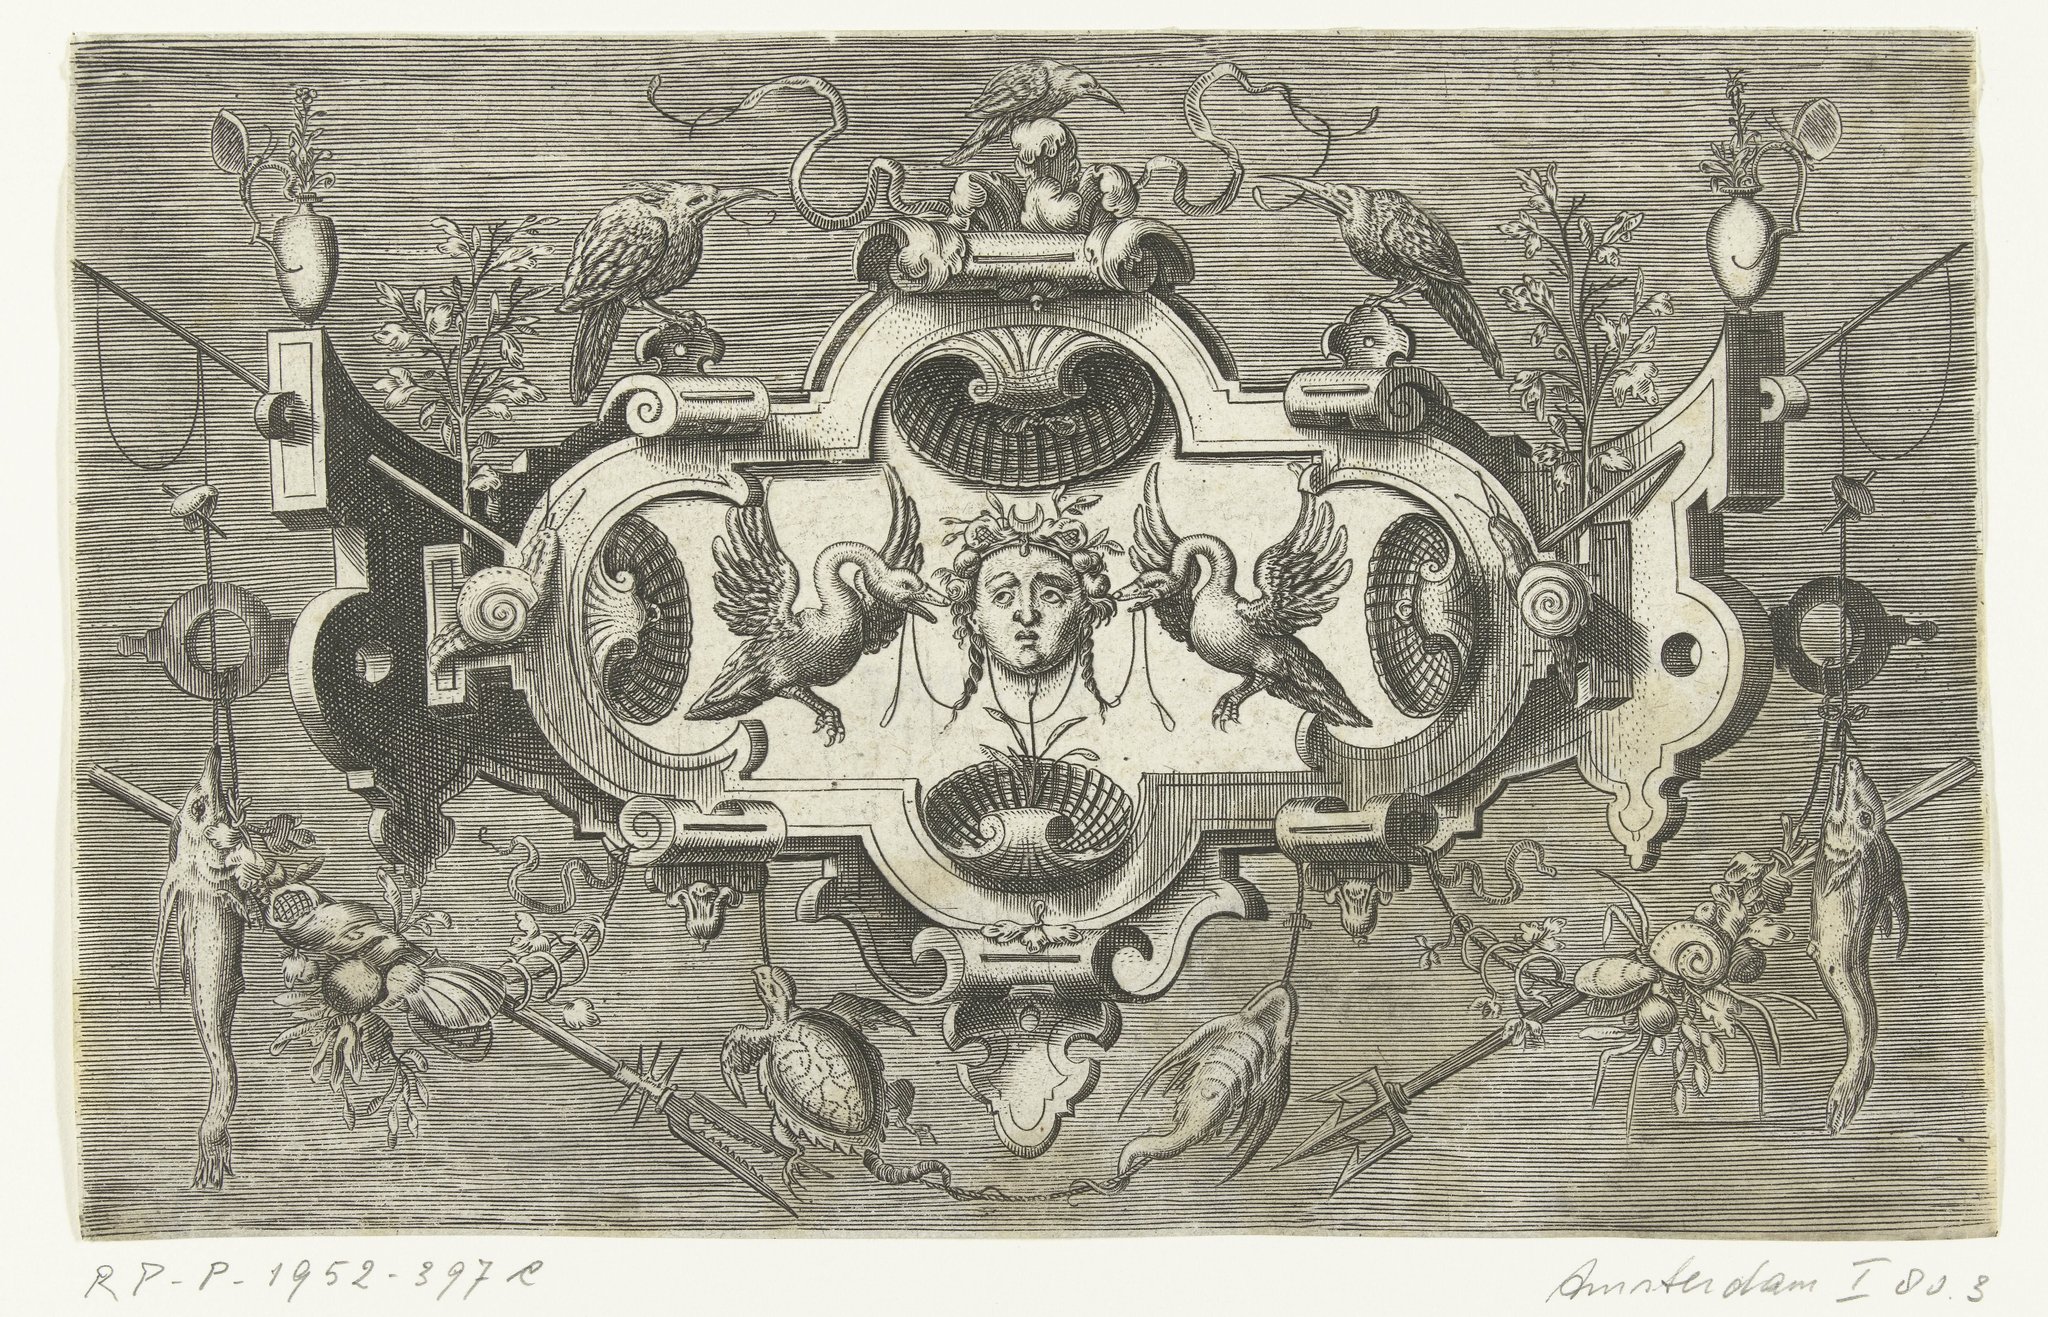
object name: print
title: Cartouche met vier schelpen en een mascaron geflankeerd door twee zwanen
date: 1564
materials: paper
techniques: engraving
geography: antwerp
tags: tortoises, turtles, water-birds: swan, birds, fishes, scallop, shell ~ ornament, ornament ~ cartouche, mask, mascaron ~ ornament, attributes of neptune: trident, molluscs: snail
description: Cartouche met vier schelpen en een mascaron geflankeerd door twee zwanen, in een omlijsting van rolwerk. Daarop twee slakken. Op de cartouche twee vazen en drie vogels. Aan de cartouche hangen een tweetand en een drietand vissen en een schildpad. Onderdeel van serie met titelblad en 12 bladen.